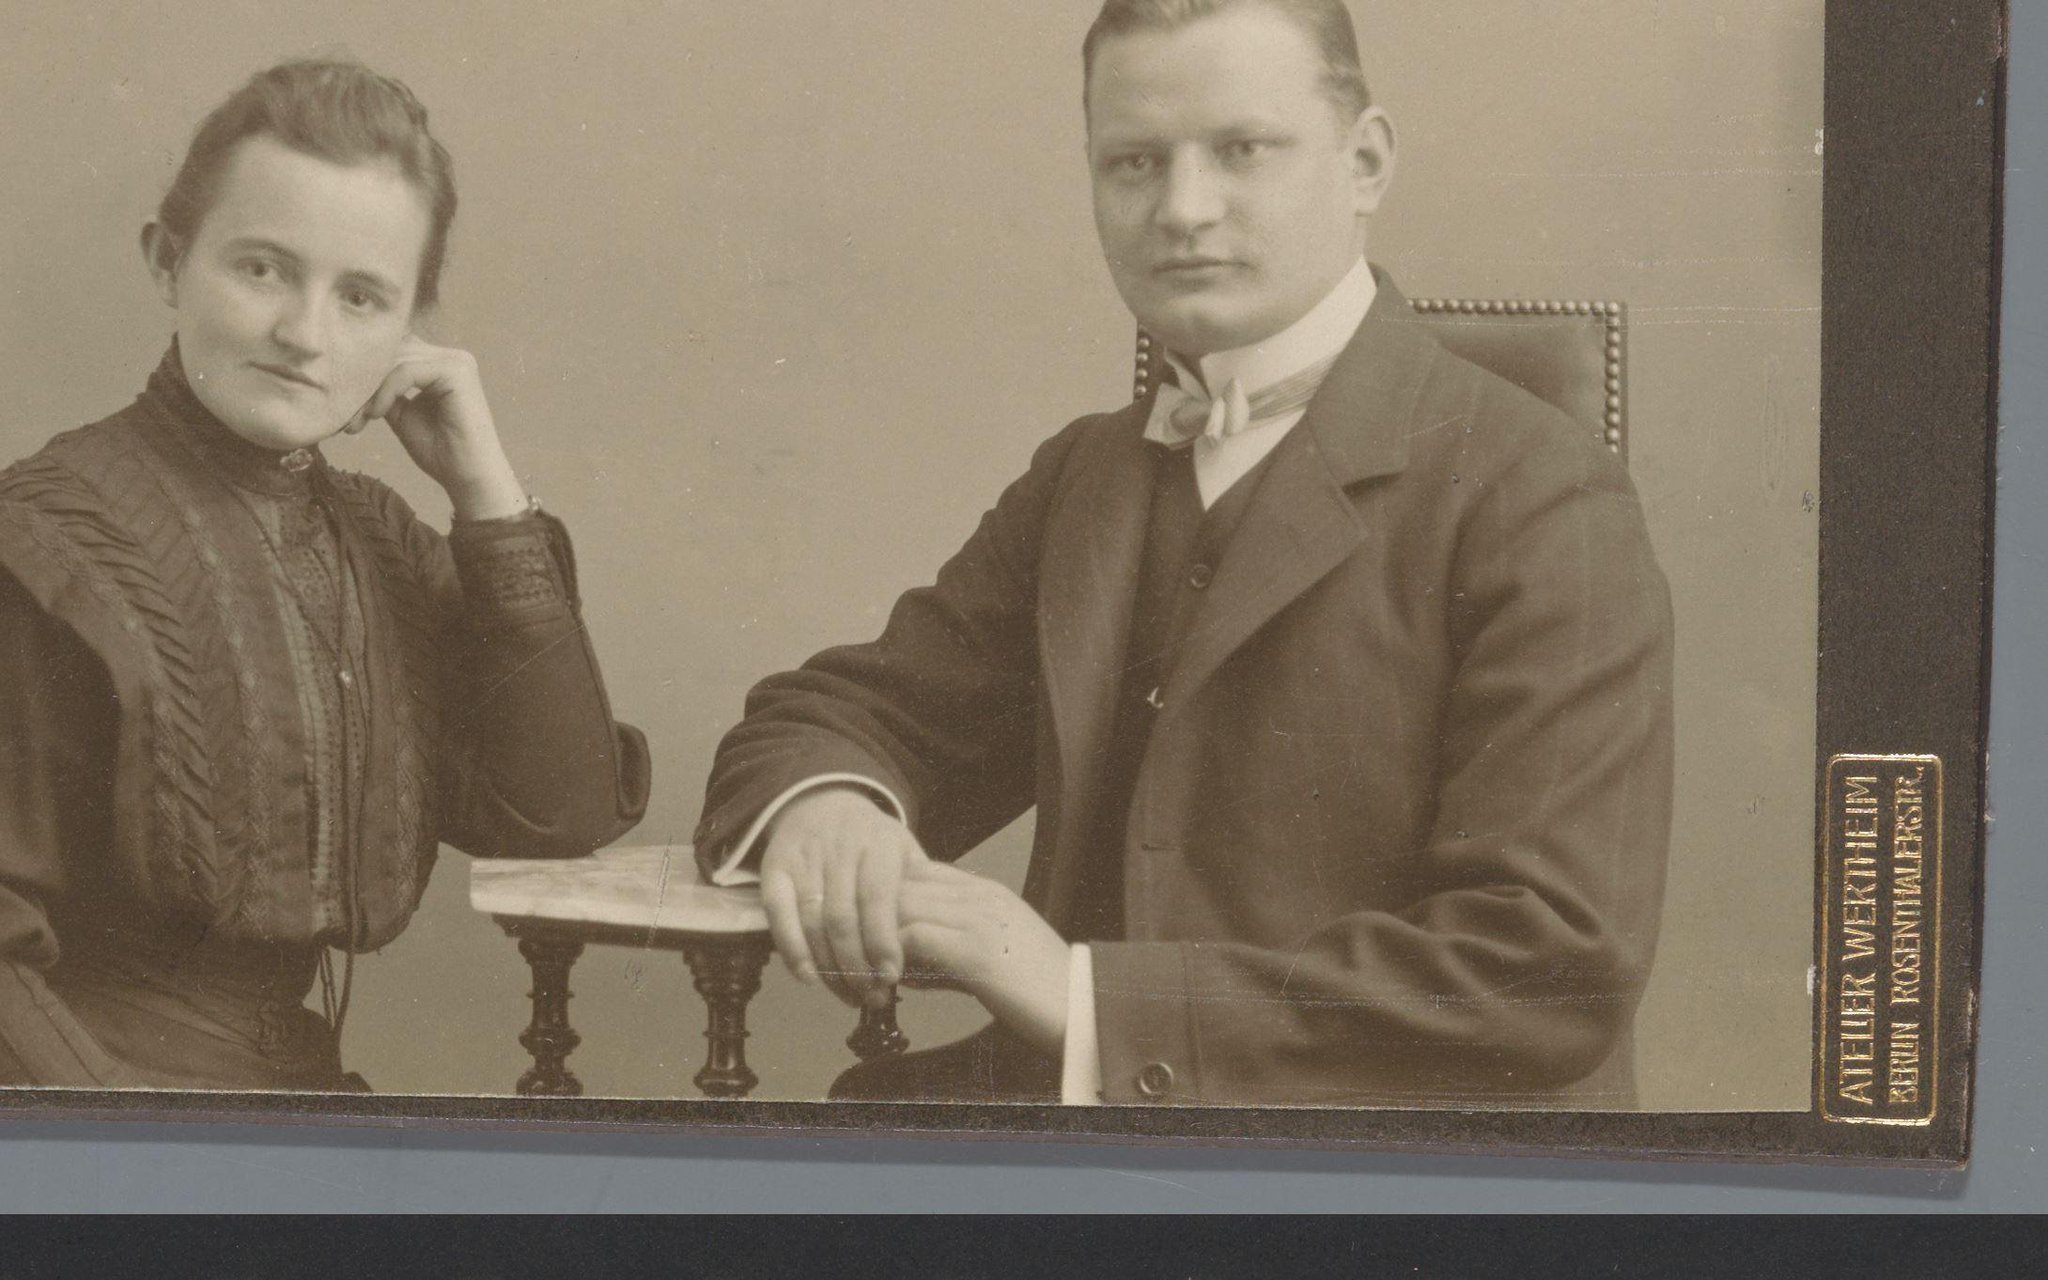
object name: carte de visite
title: Portret van een onbekende man en vrouw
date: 1900-1914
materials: paper, cardboard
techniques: gelatin silver print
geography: leipzig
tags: adult woman, adult man, anonymous historical person portrayed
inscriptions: address: ‘ROSENTHALERSTR.’, number: ‘372’